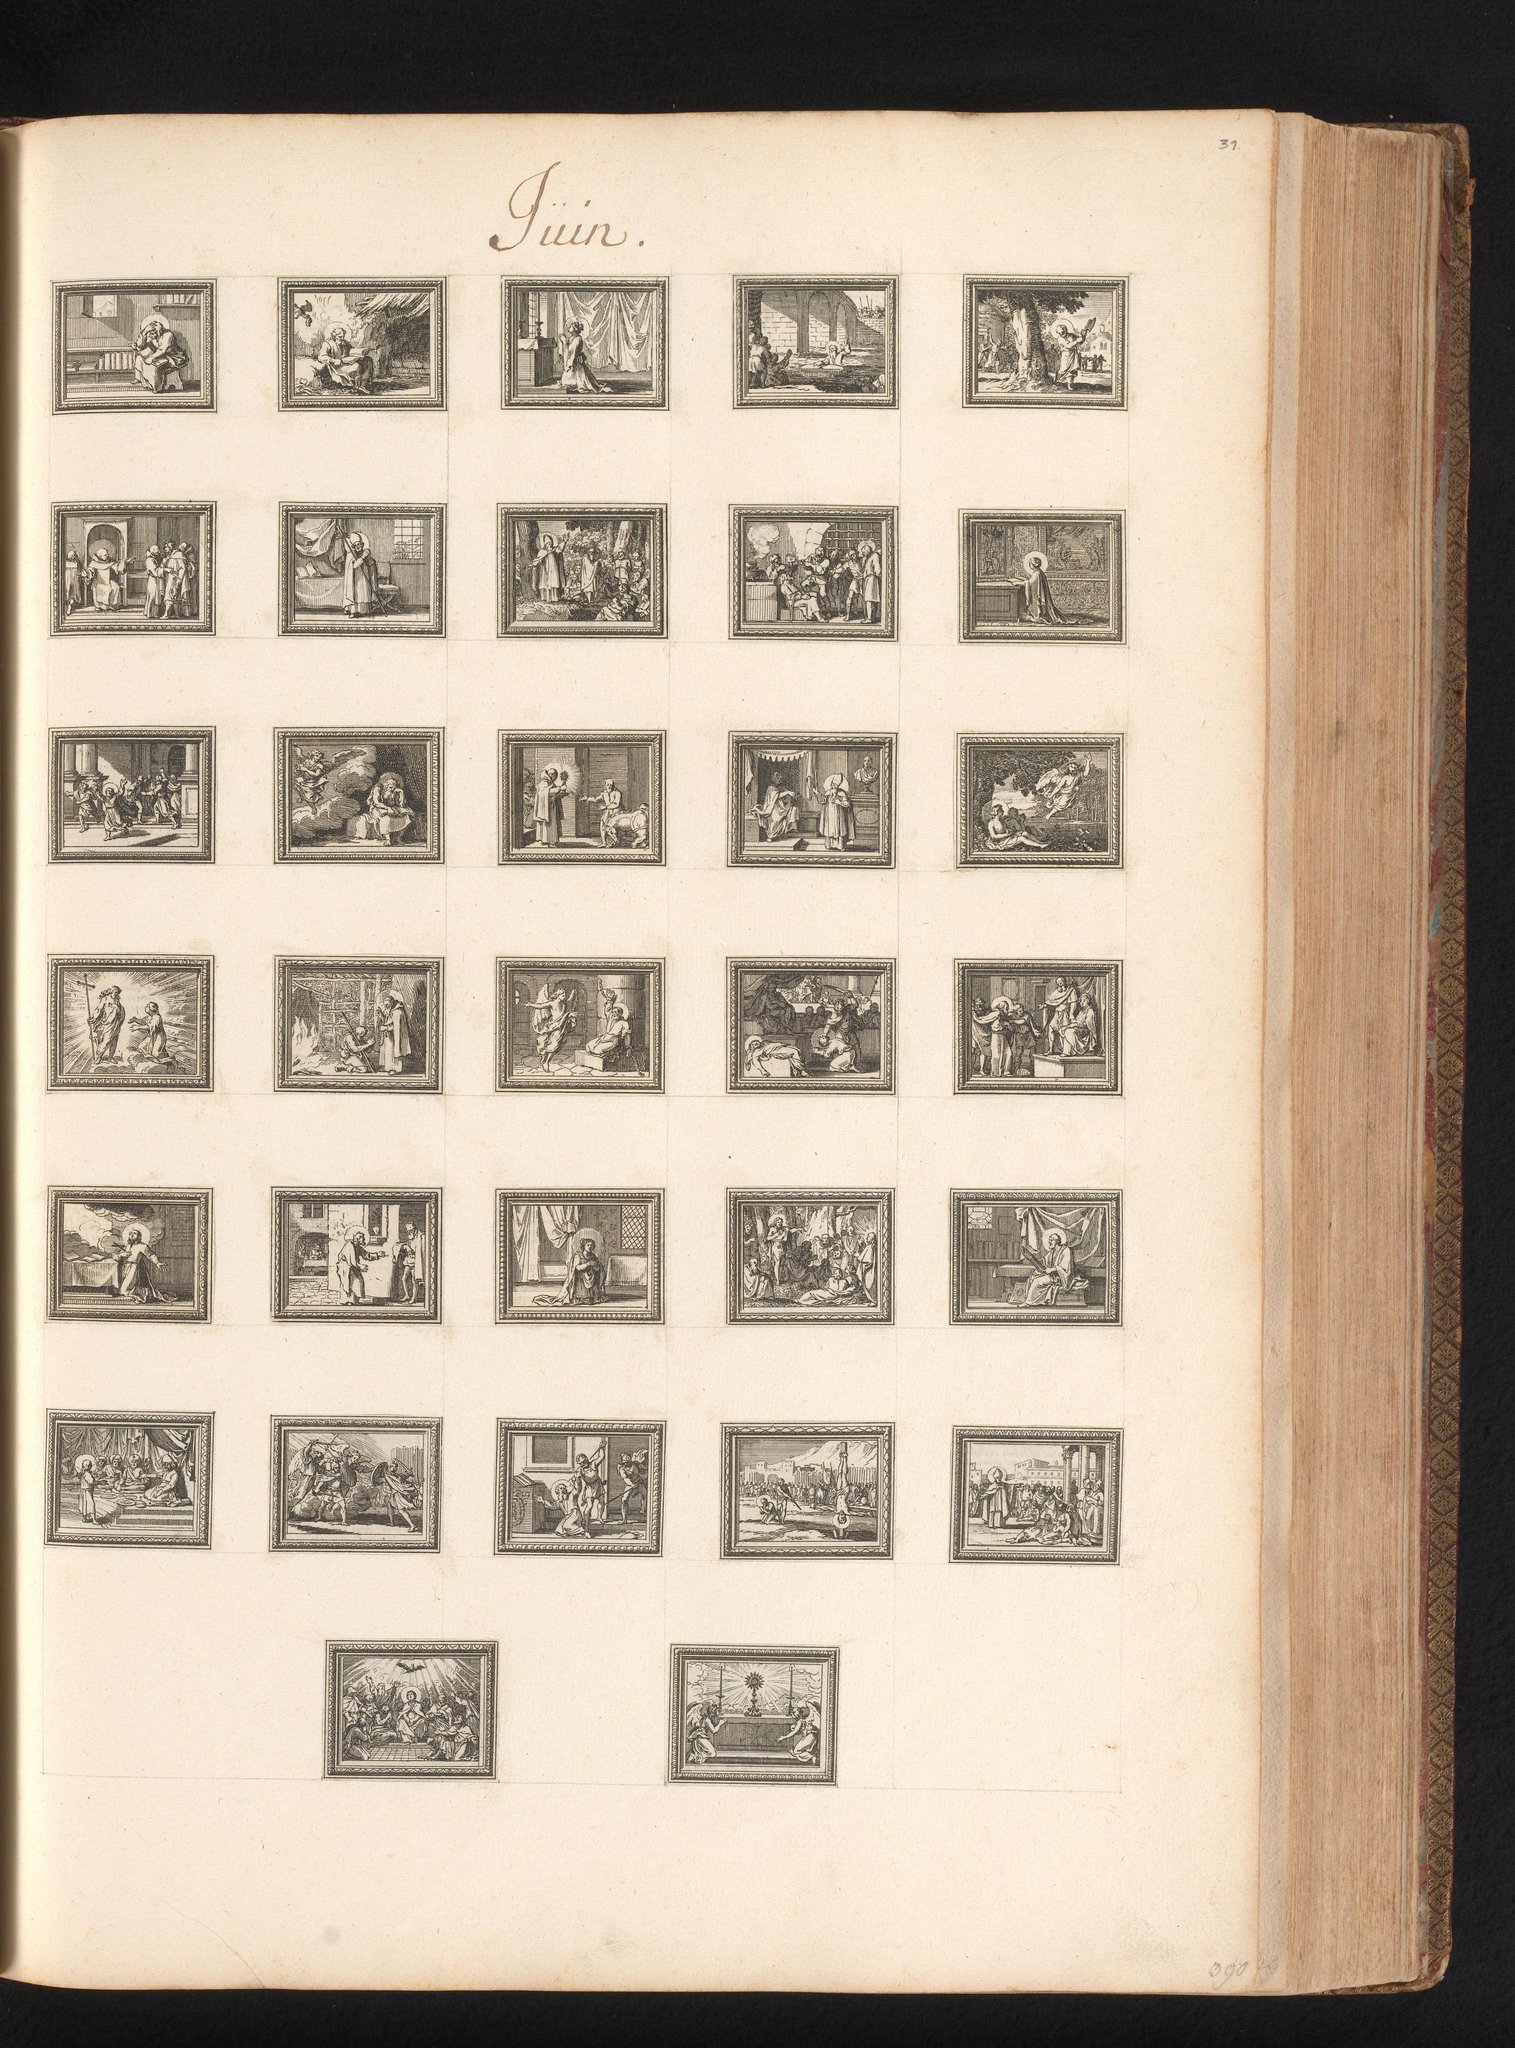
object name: book illustration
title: Heiligen van de maand juni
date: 1687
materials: ink, paper, pencil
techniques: etching, pen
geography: paris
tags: saints, june ~ other concepts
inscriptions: inscription: ‘Juin.’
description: Prenten gebruikt voor: Giraud, L'Abbé. L'invocation et l'imitation des saints pour tous les jours de l'année. Parijs: Gérard Audran, 1687, 4 vols. Deze prenten staan ook wel bekend als de 'Saints d'Audran', zie IFF 17e siècle dl. 9, p. 118-119, nr. 1796-2174.